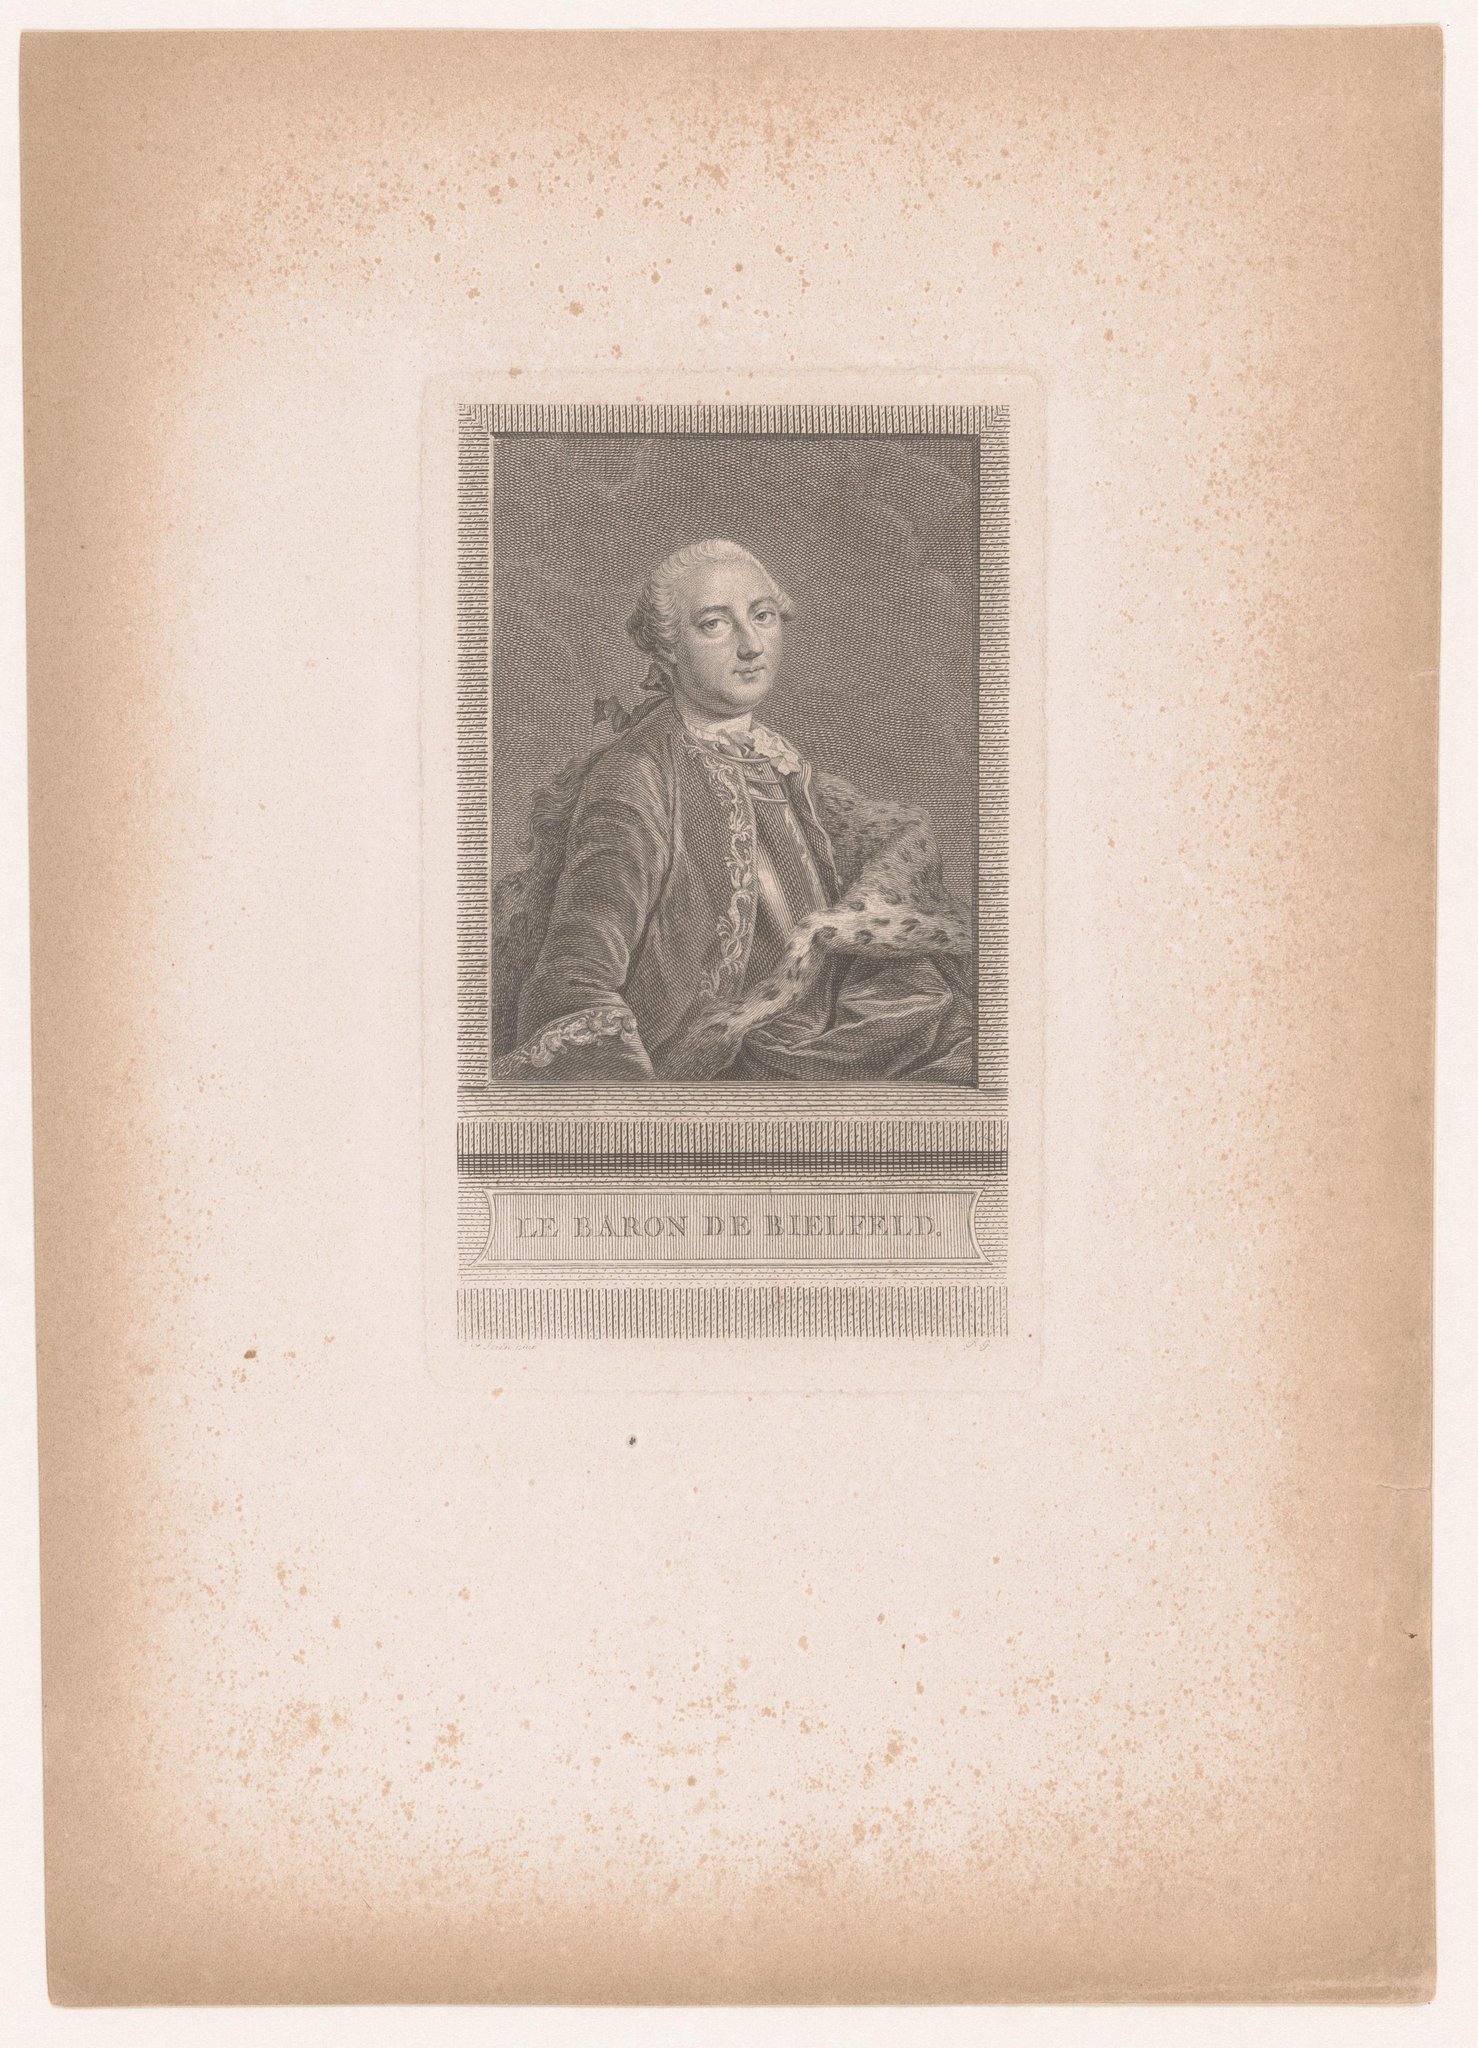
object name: print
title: Portret van Jakob Friedrich van Bielfeld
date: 1740-1766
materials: paper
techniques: engraving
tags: historical persons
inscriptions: collector's mark: Lugt 2228